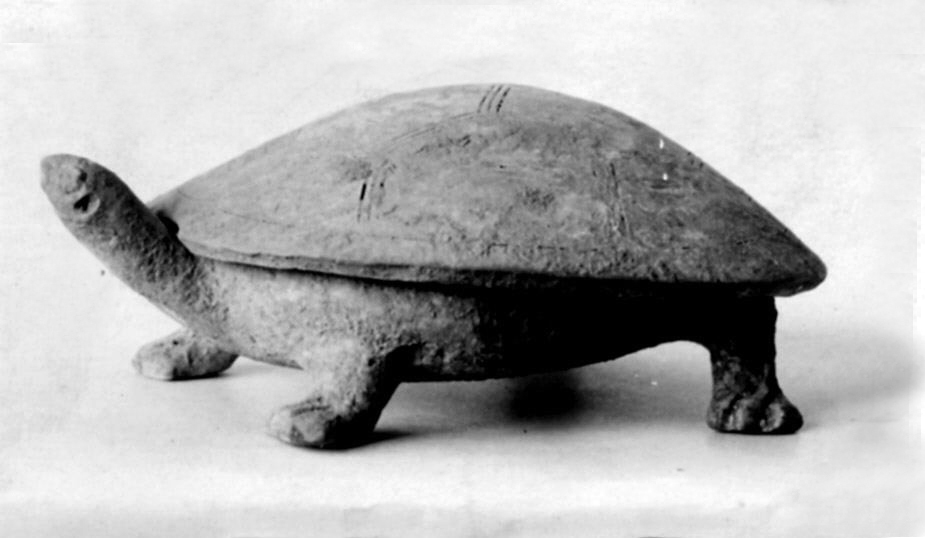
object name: rouge box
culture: chinese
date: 206 BCE-220 CE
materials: clay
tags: turtles